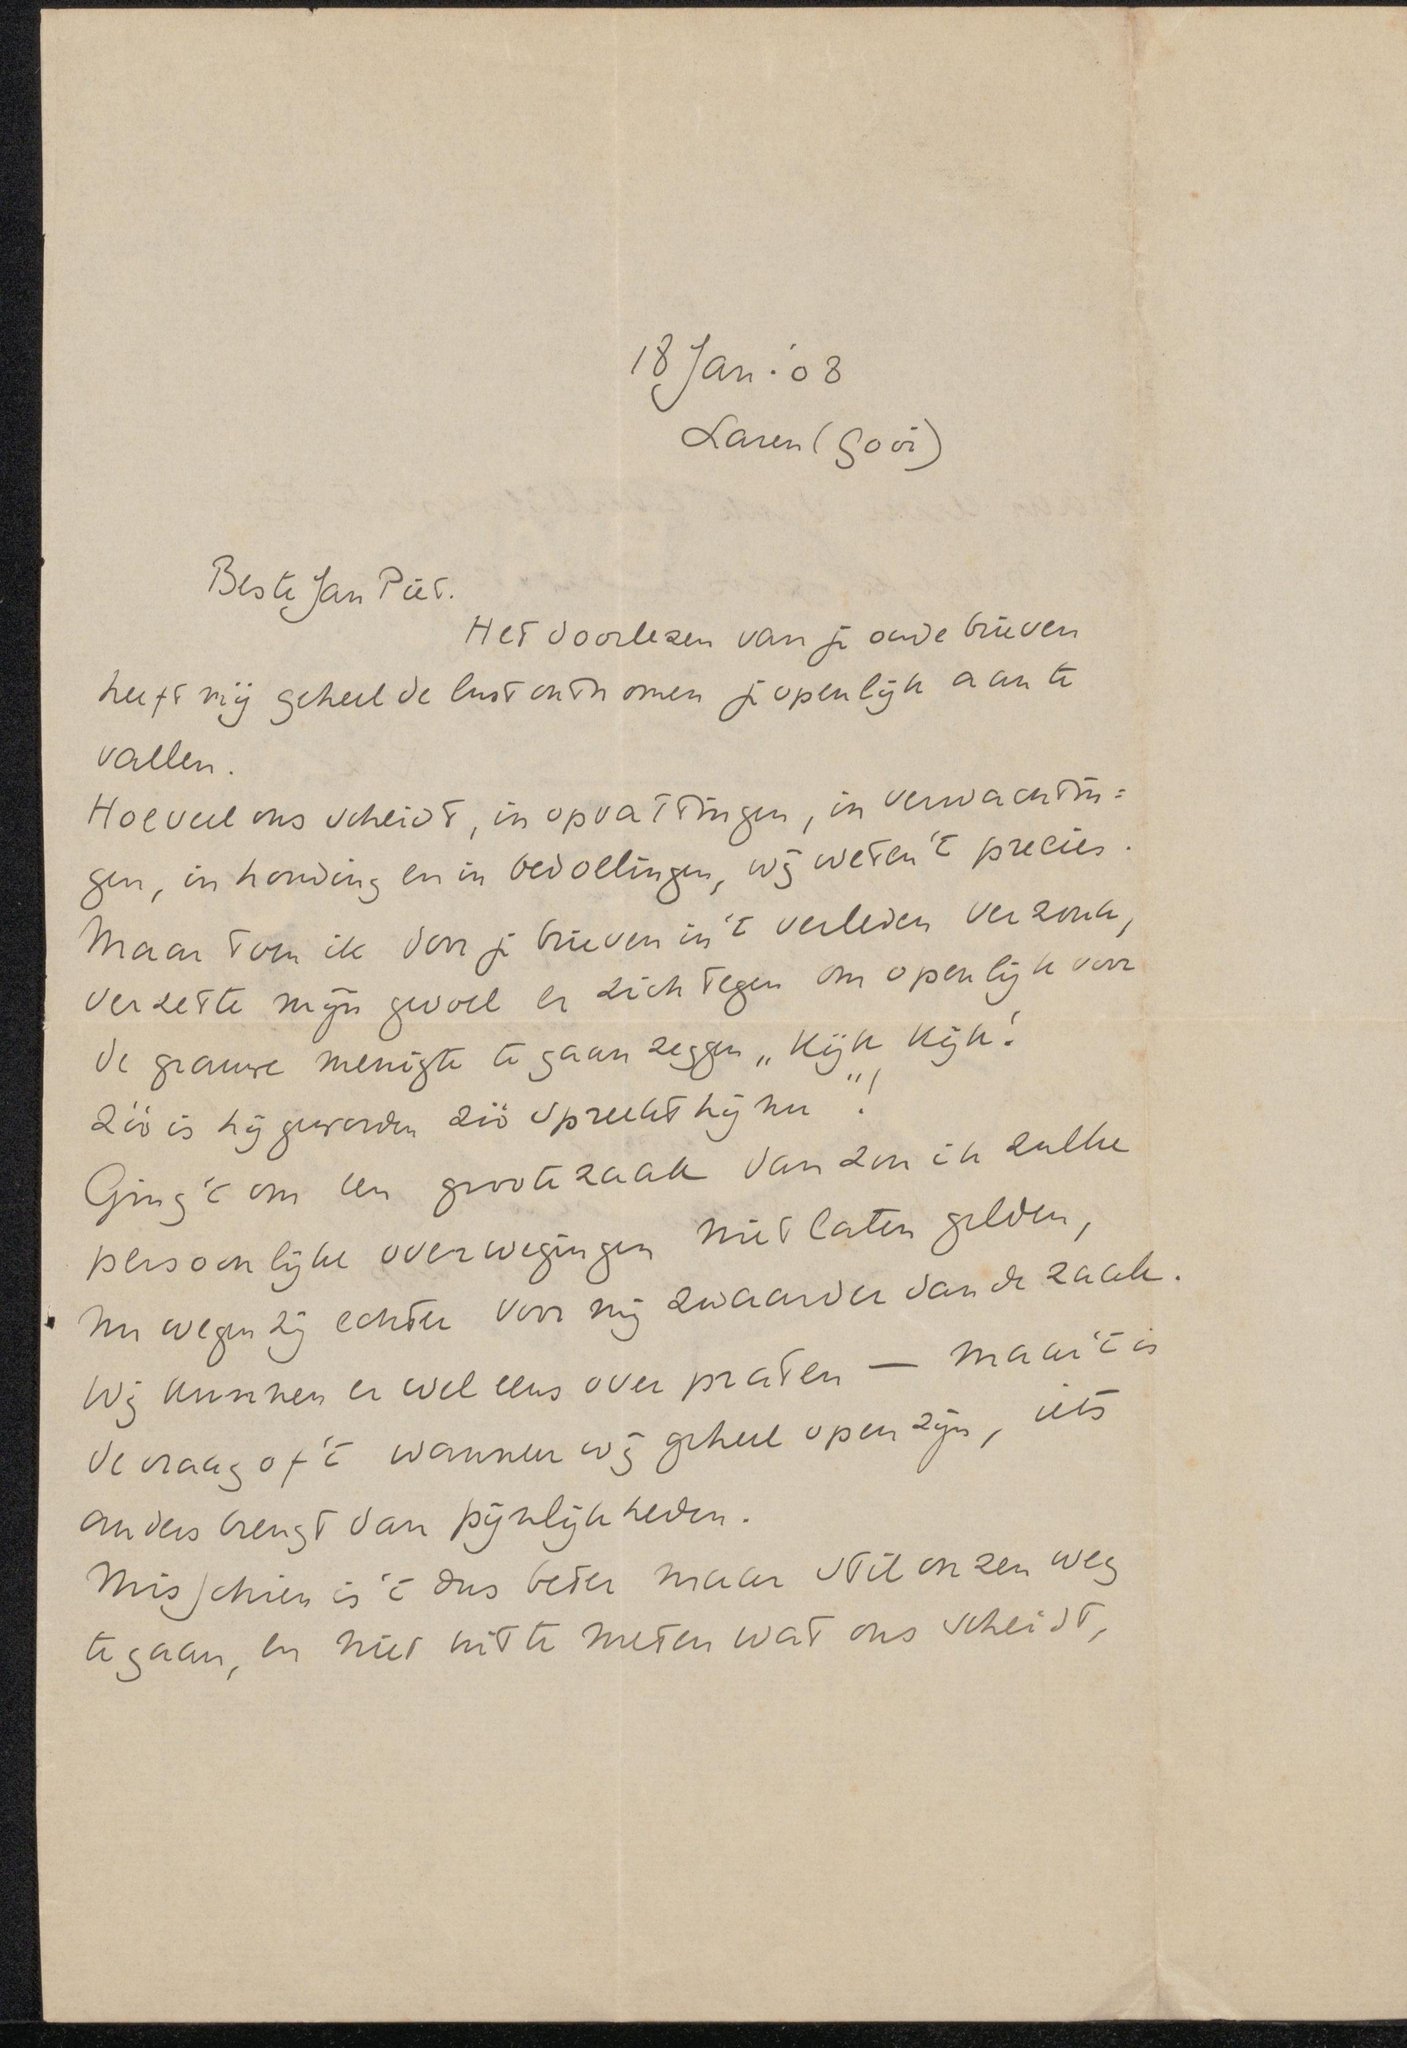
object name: letter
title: Brief aan Jan Veth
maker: richard nicolaüs roland holst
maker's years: 1868-1938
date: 1908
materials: ink, paper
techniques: pen, writing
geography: laren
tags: painter, print maker, draughtsman, designer, jan veth, passions, emotions, affections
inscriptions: collector's mark: ‘RPK’, watermark